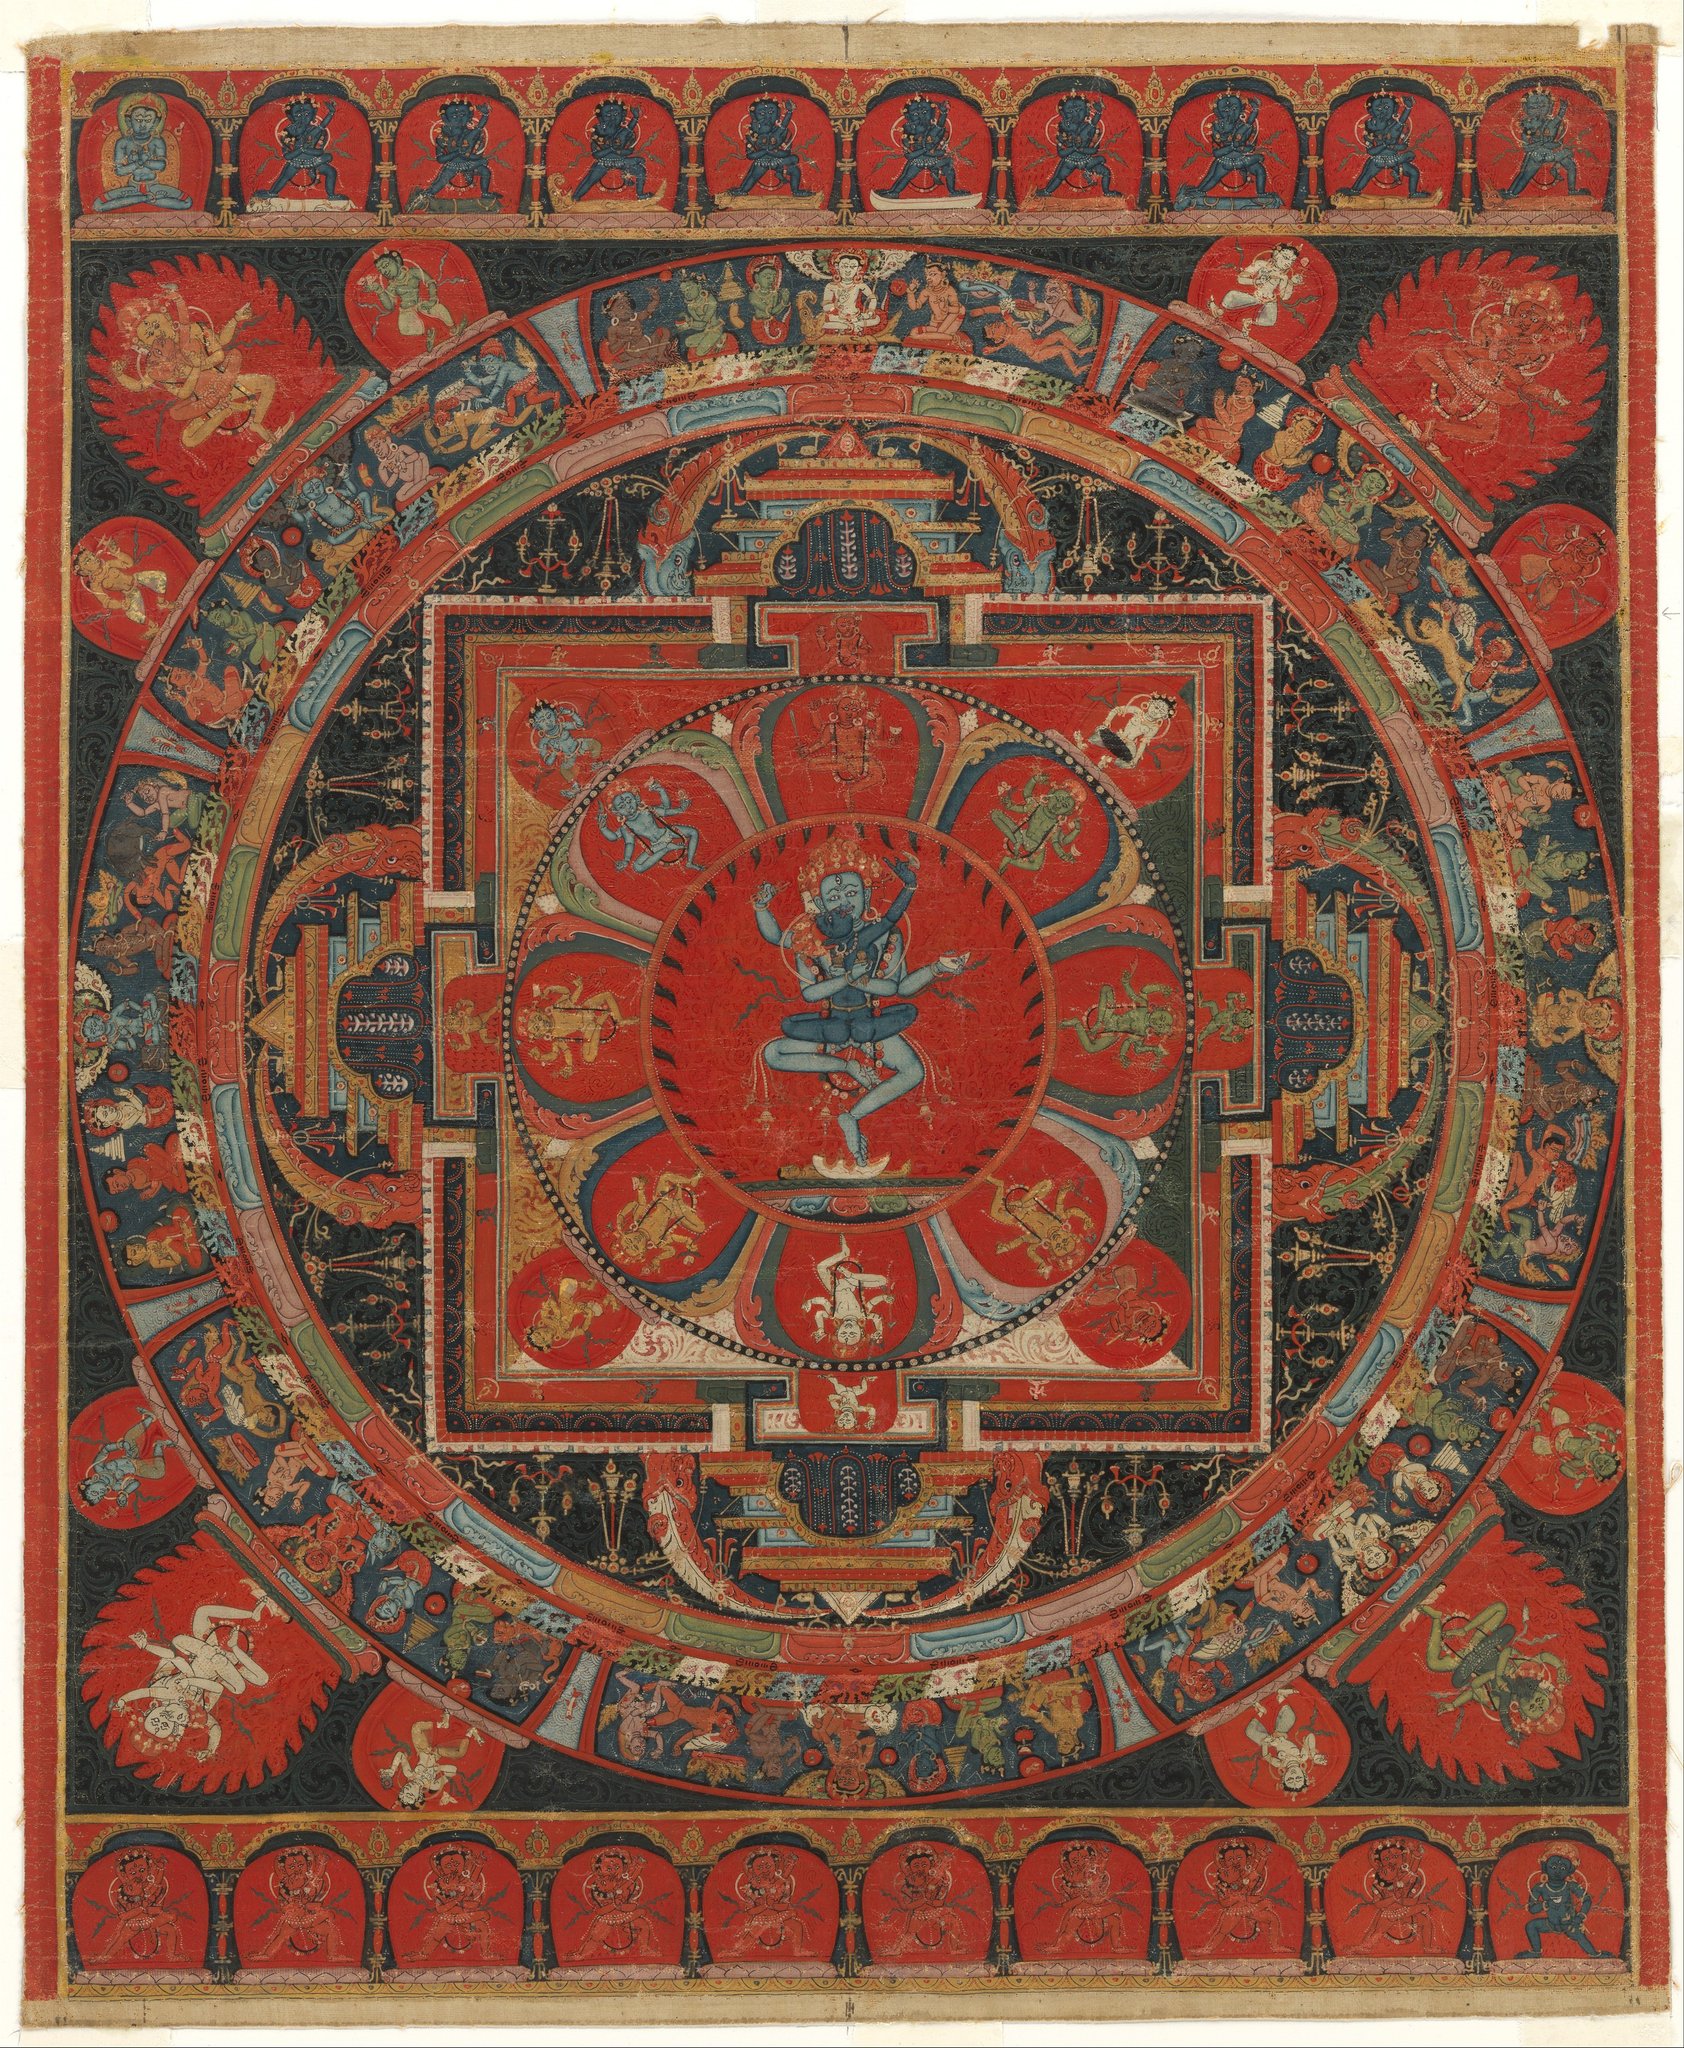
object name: thangka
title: Hevajra Mandala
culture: tibetan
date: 1401-1500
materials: textile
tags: couples,buddhism,deities